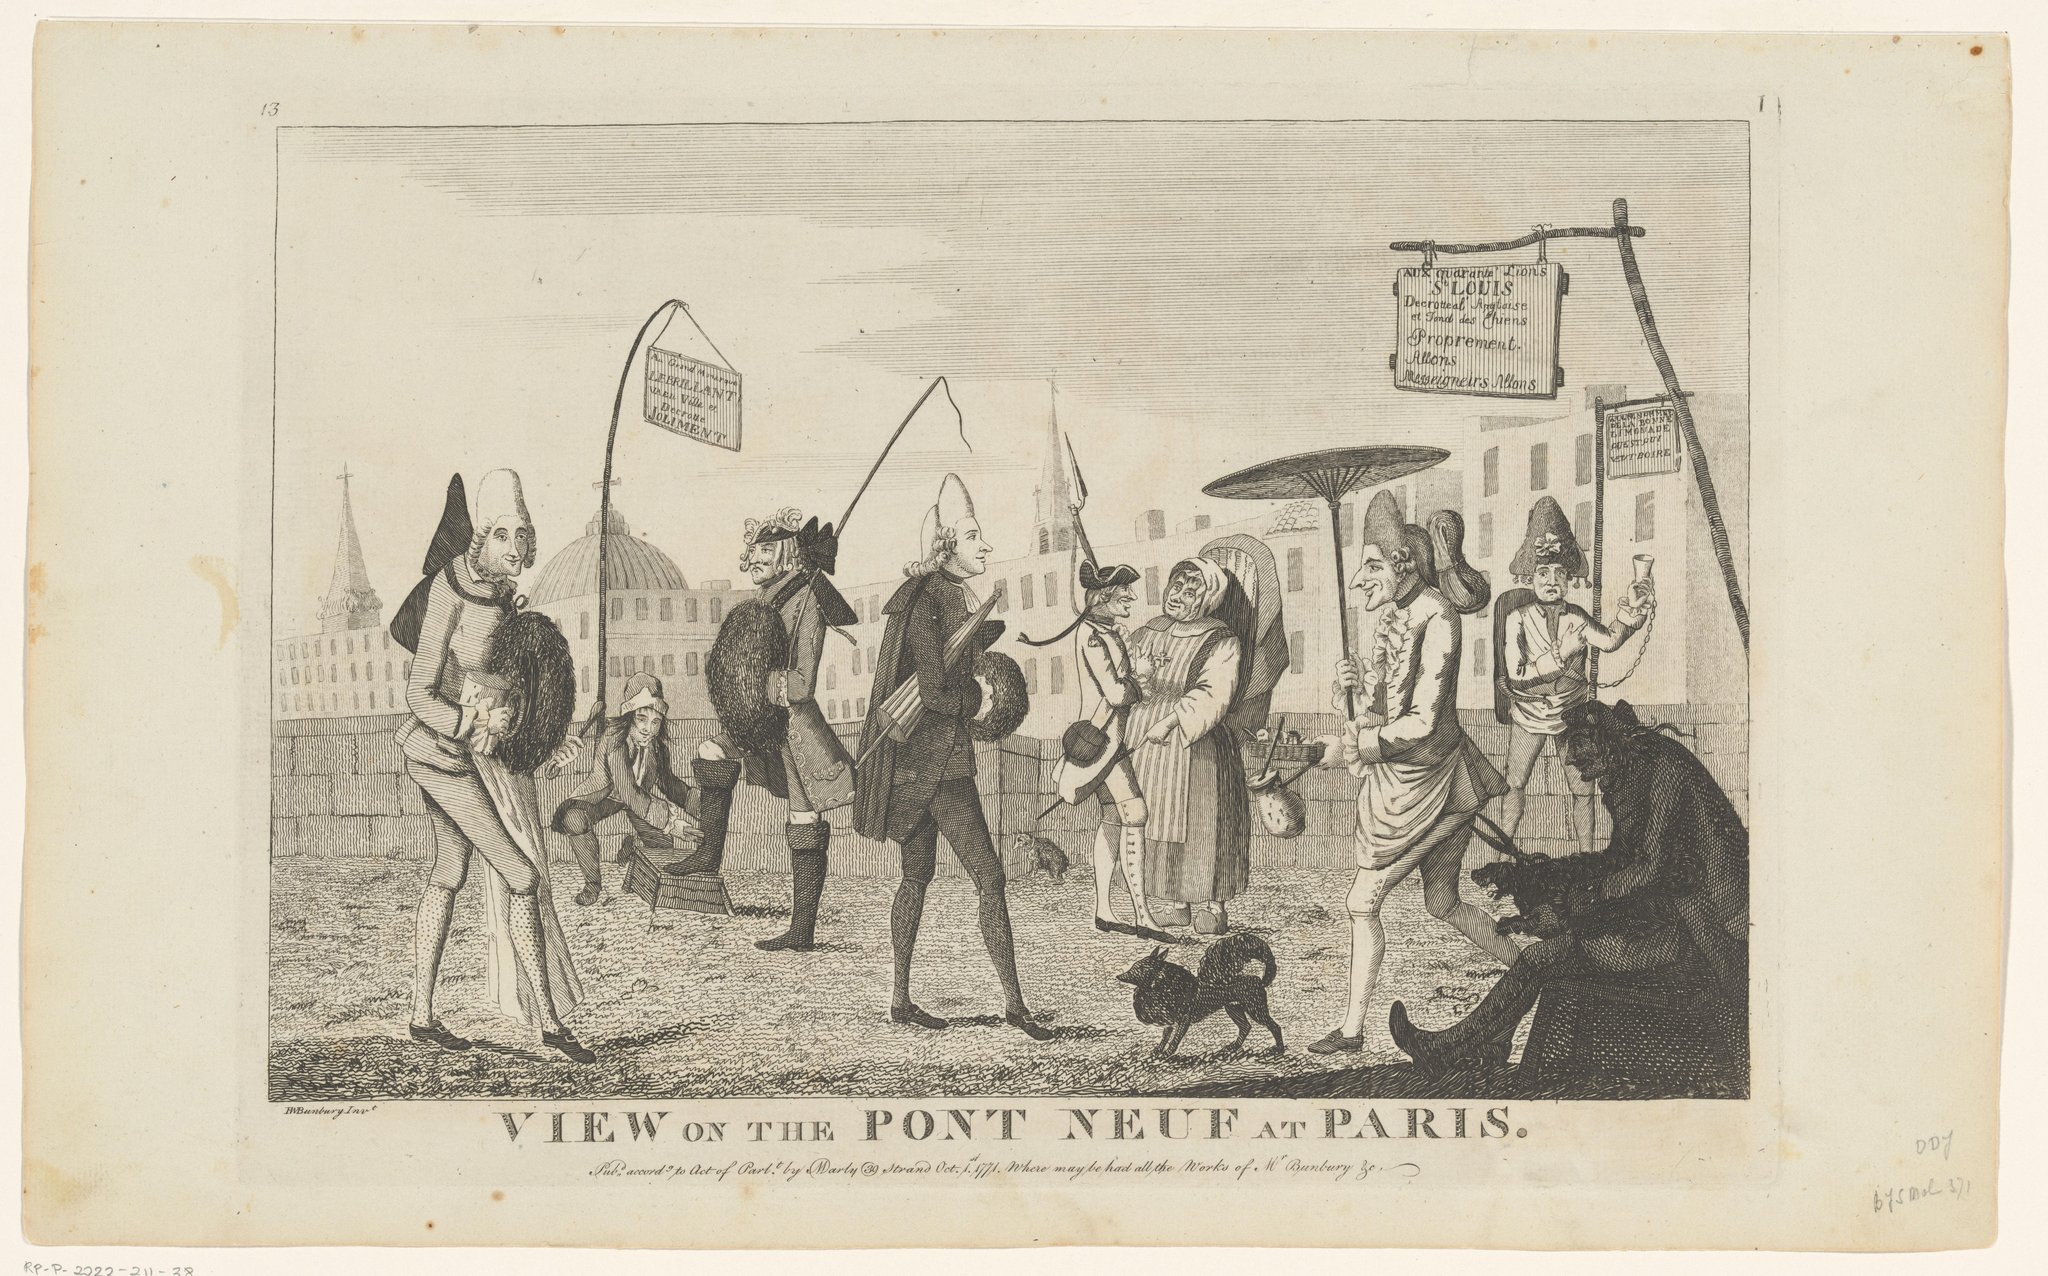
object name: cartoon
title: Straatventers op de Pont Neuf in Parijs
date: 1771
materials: paper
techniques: etching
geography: europe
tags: accessories ~ shoes, e.g. insole, shoehorn, shoe-polish, caricatures (human types), europeans: french (+ caricatured), street-trader, dog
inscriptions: collector's mark: Lugt 2228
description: Satire op het Parijse straatleven. Verschillende straatventers in de weer op de Pont Neuf, onder wie een hondenkapper, een schoenenpoetsen en een chocoladeverkoper. Nummer 13 uit een serie.